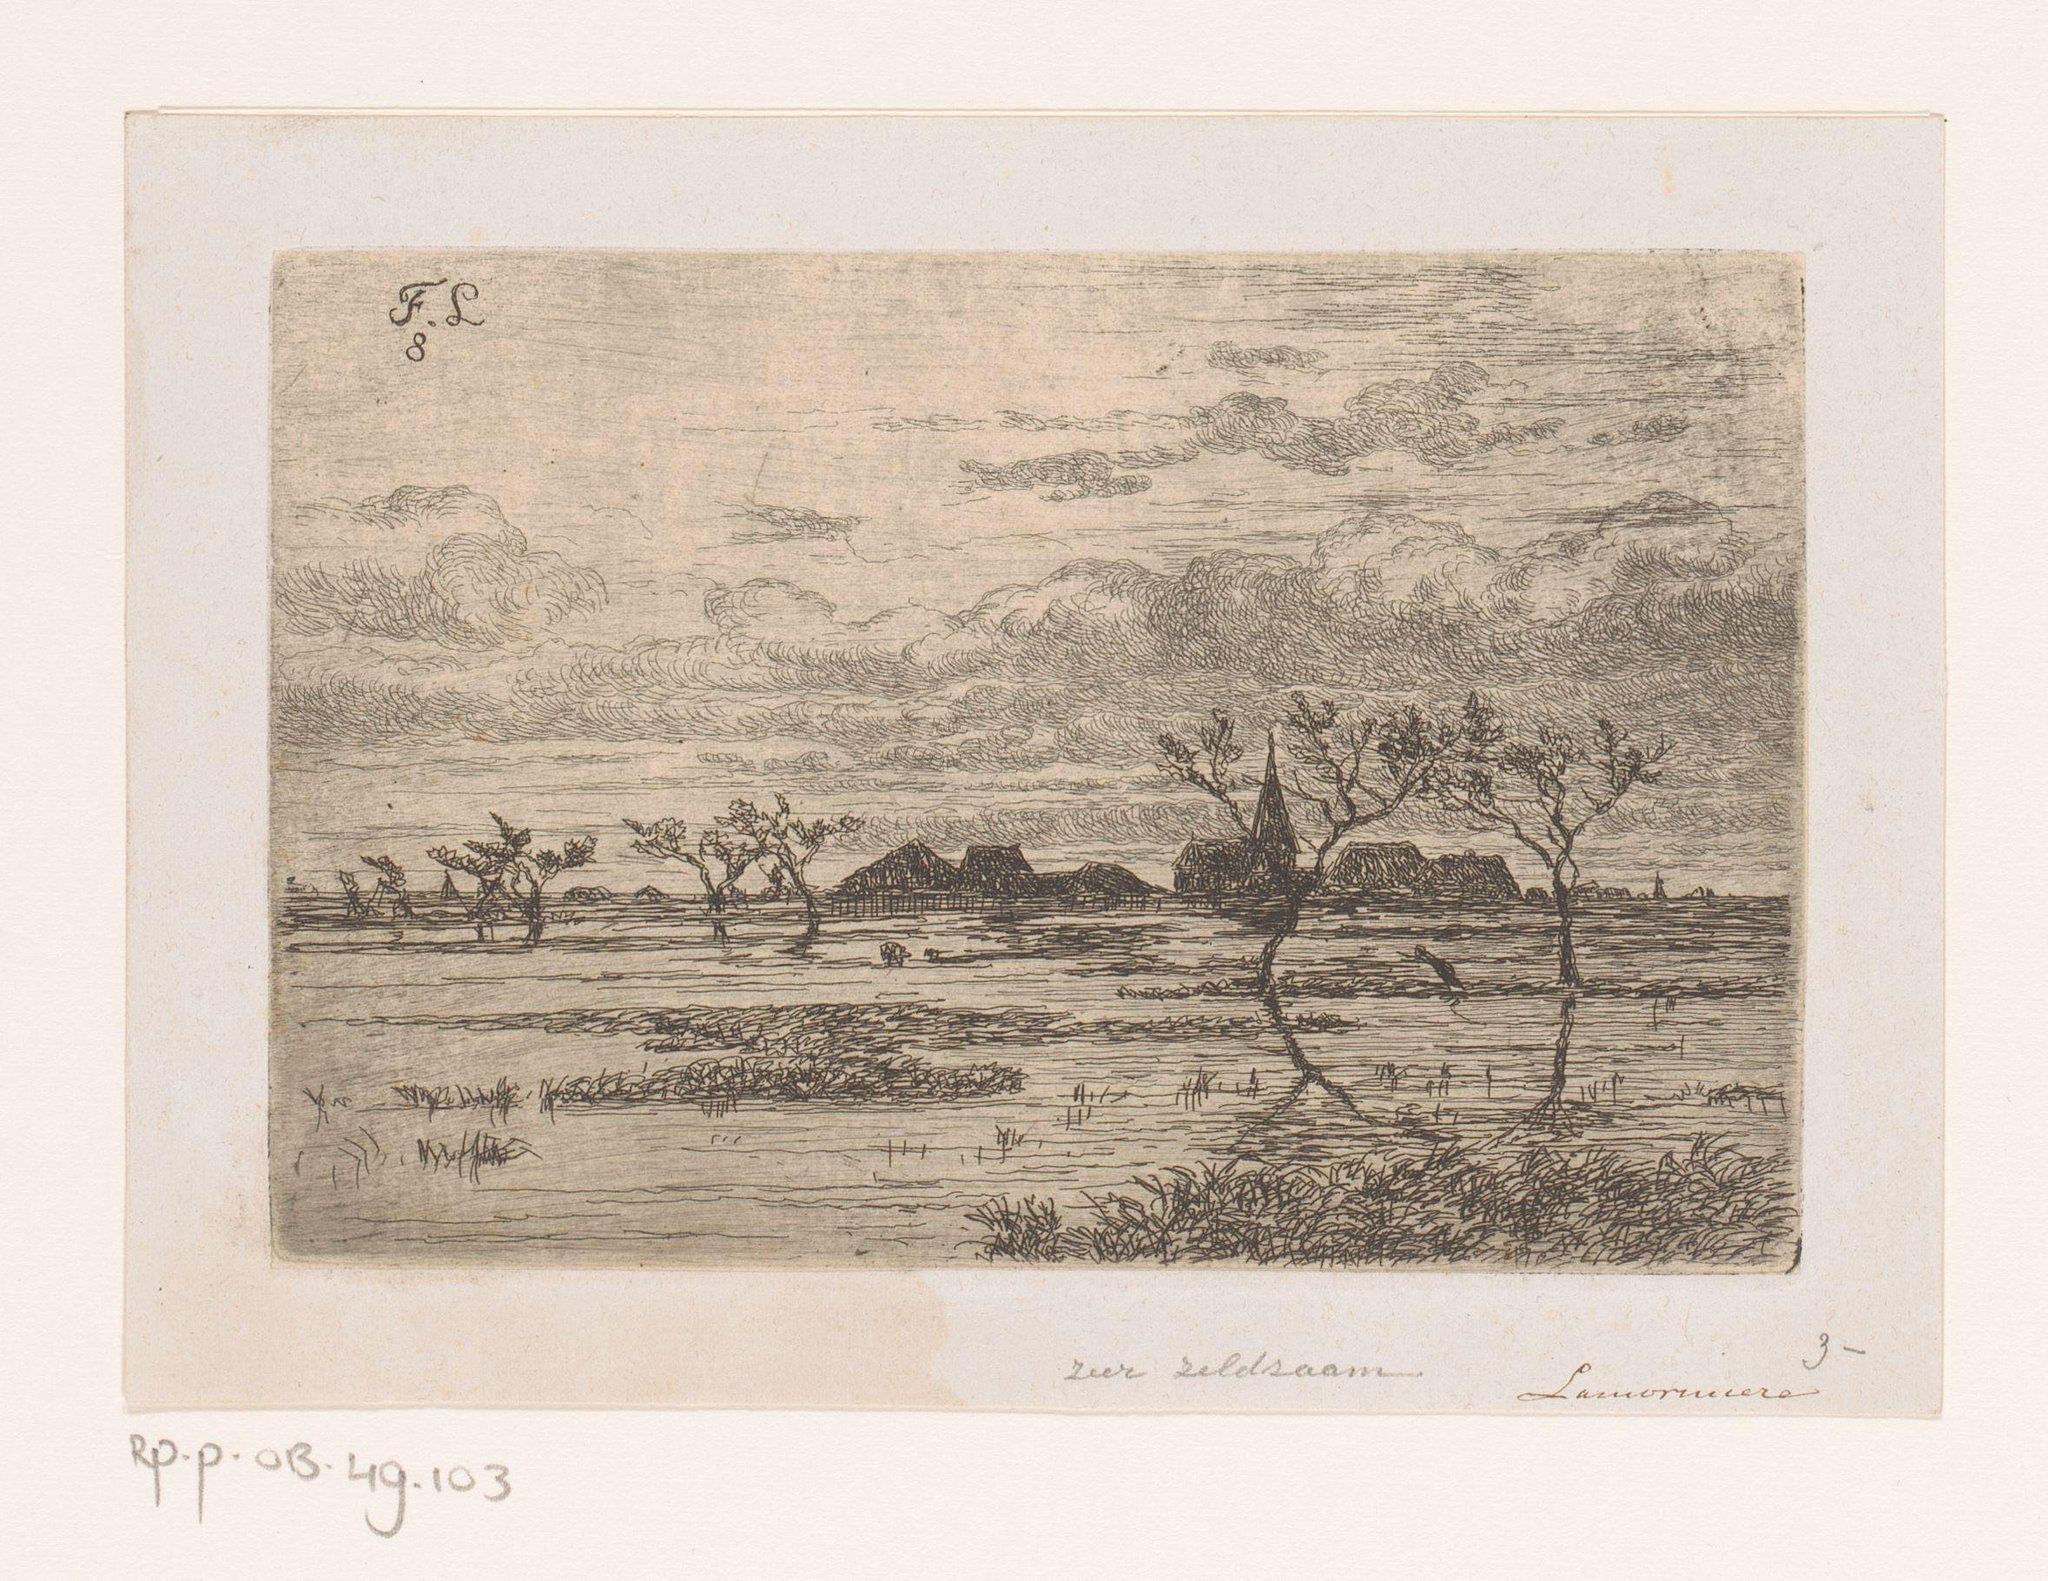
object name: print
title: Overstroming in de polders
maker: jean pierre françois lamorinière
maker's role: print maker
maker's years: 1828-1911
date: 1838-1911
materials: paper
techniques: etching, intaglio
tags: flood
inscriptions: collector's mark: Lugt 2228